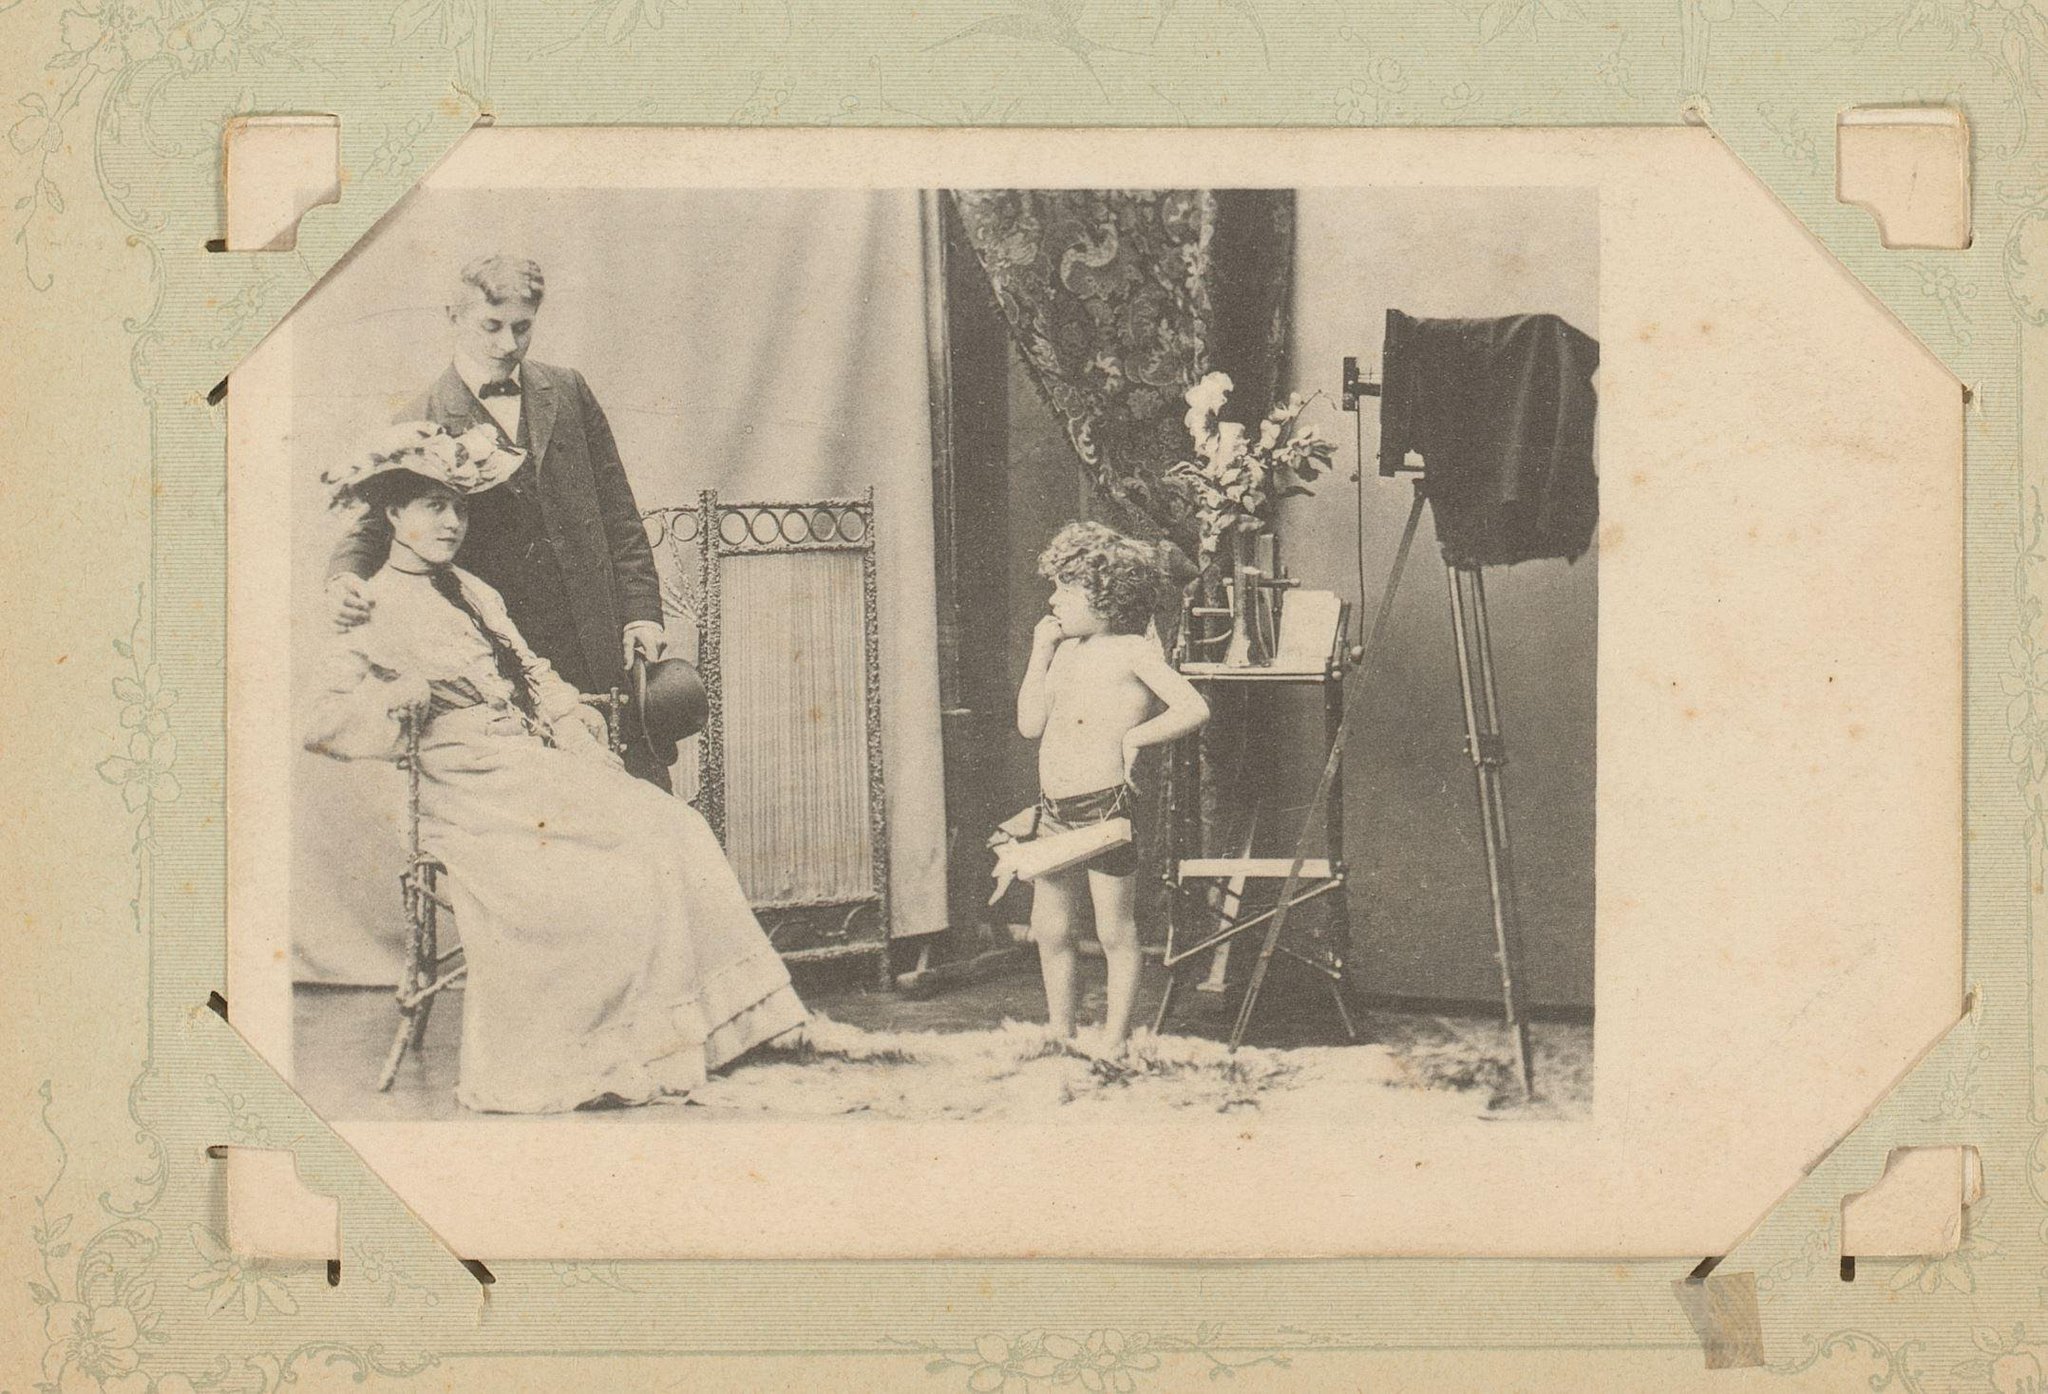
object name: album leaf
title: Man, vrouw en kind in een fotostudio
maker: Anonymous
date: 1900-1950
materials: cardboard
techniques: photograph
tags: studio ~ photographer, adult woman, camera ~ photography, adult man, child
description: Deze prent maakt deel uit van een album.